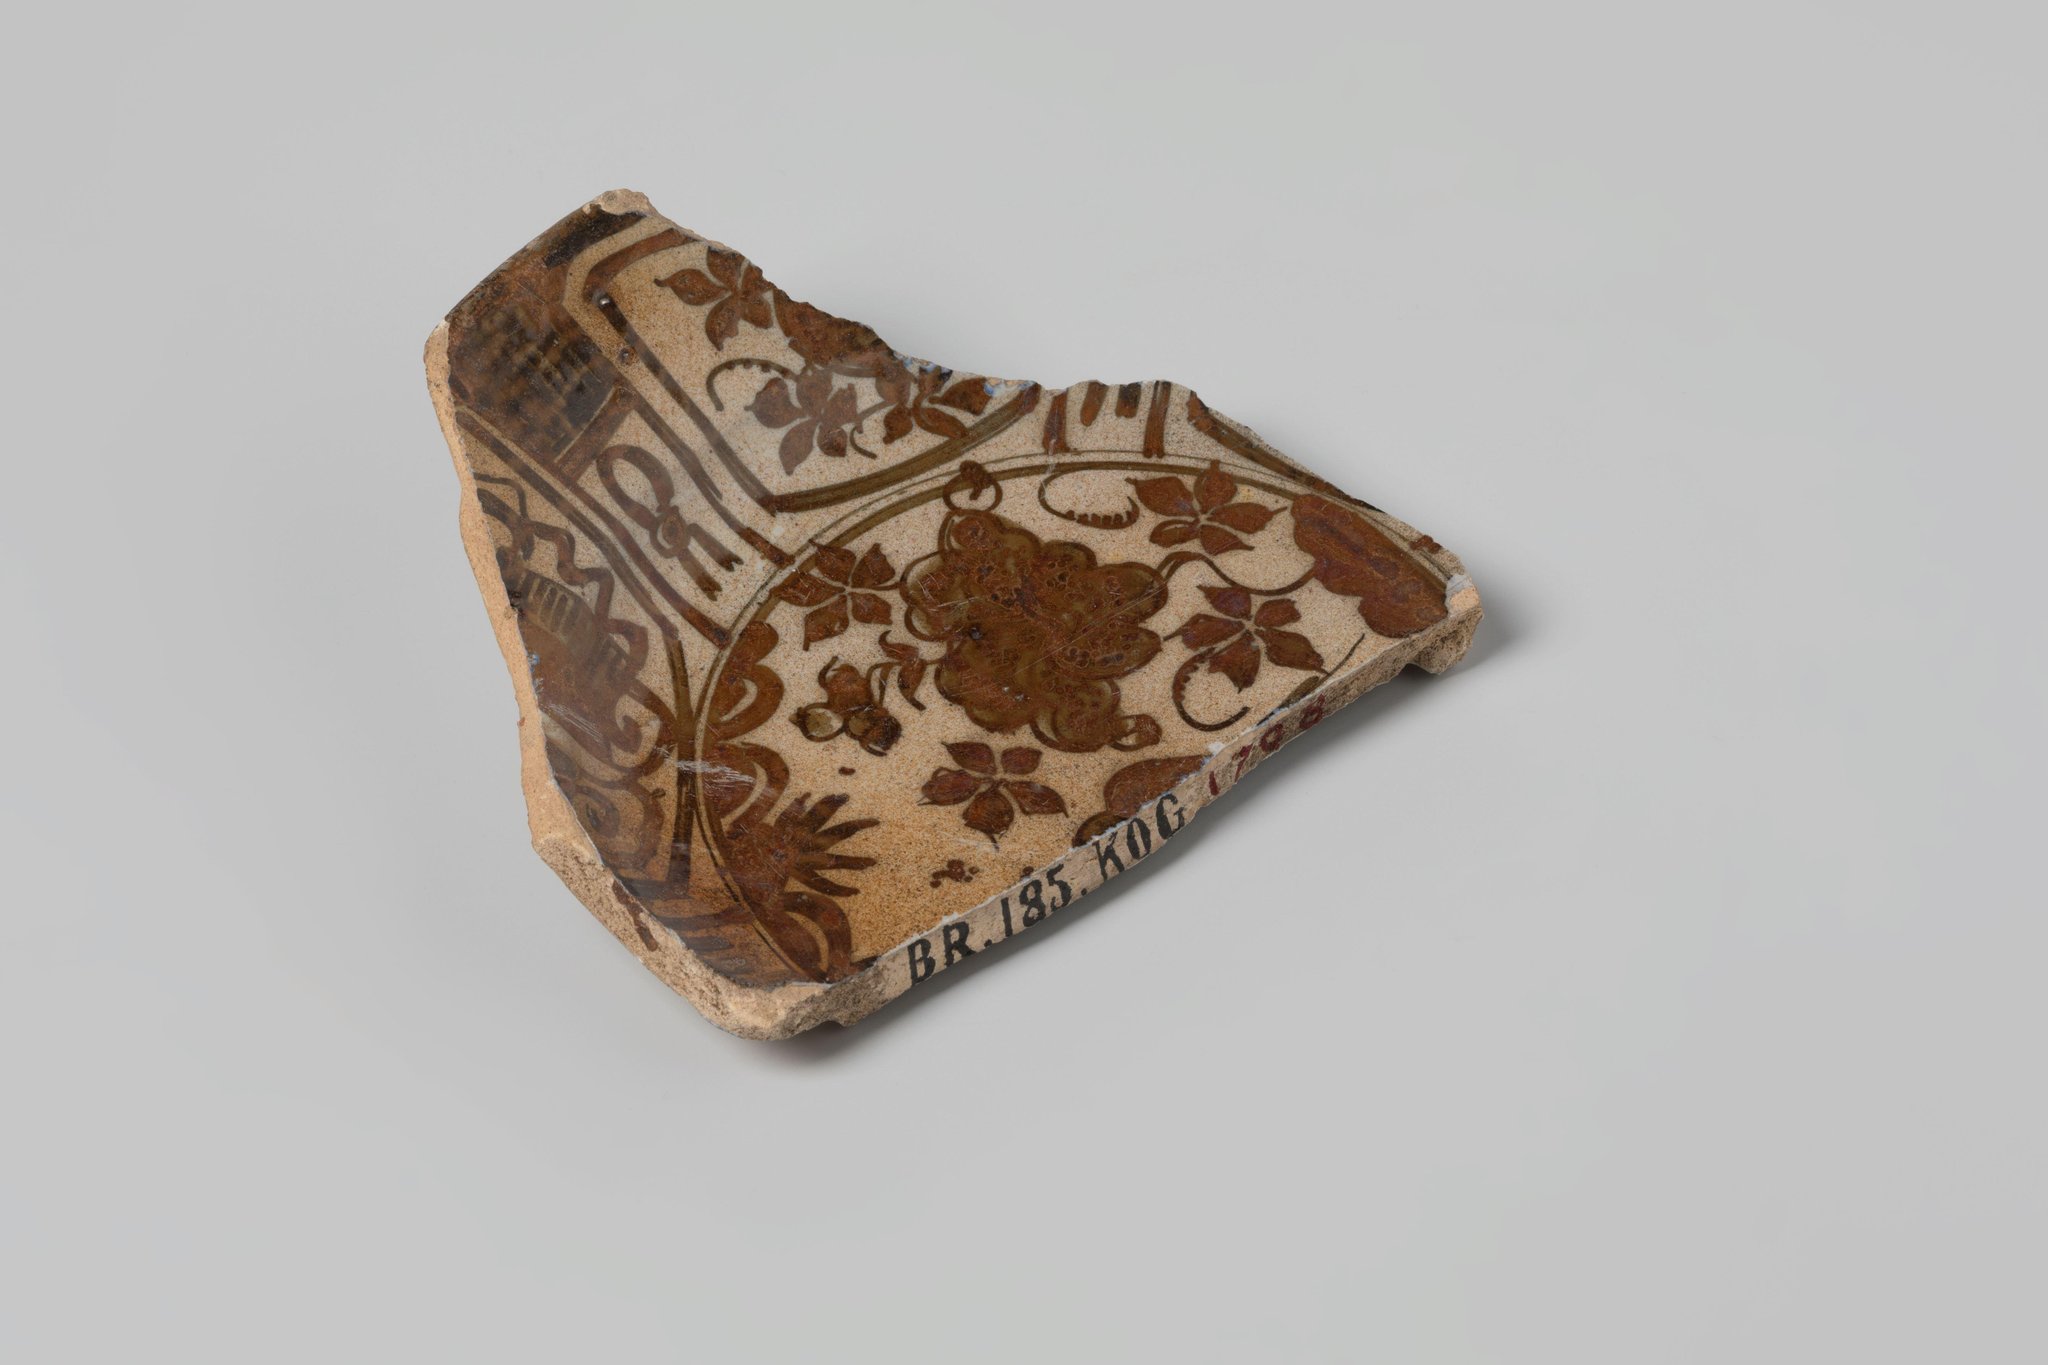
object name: sherd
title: Schotelscherf van aardewerk, voorzien van tinglazuur aan de boven- en onderzijde en eenbloemdecor in blauw aan de bovenzijde, beschadigd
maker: Anonymous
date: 1500-1799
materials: earthenware, glaze